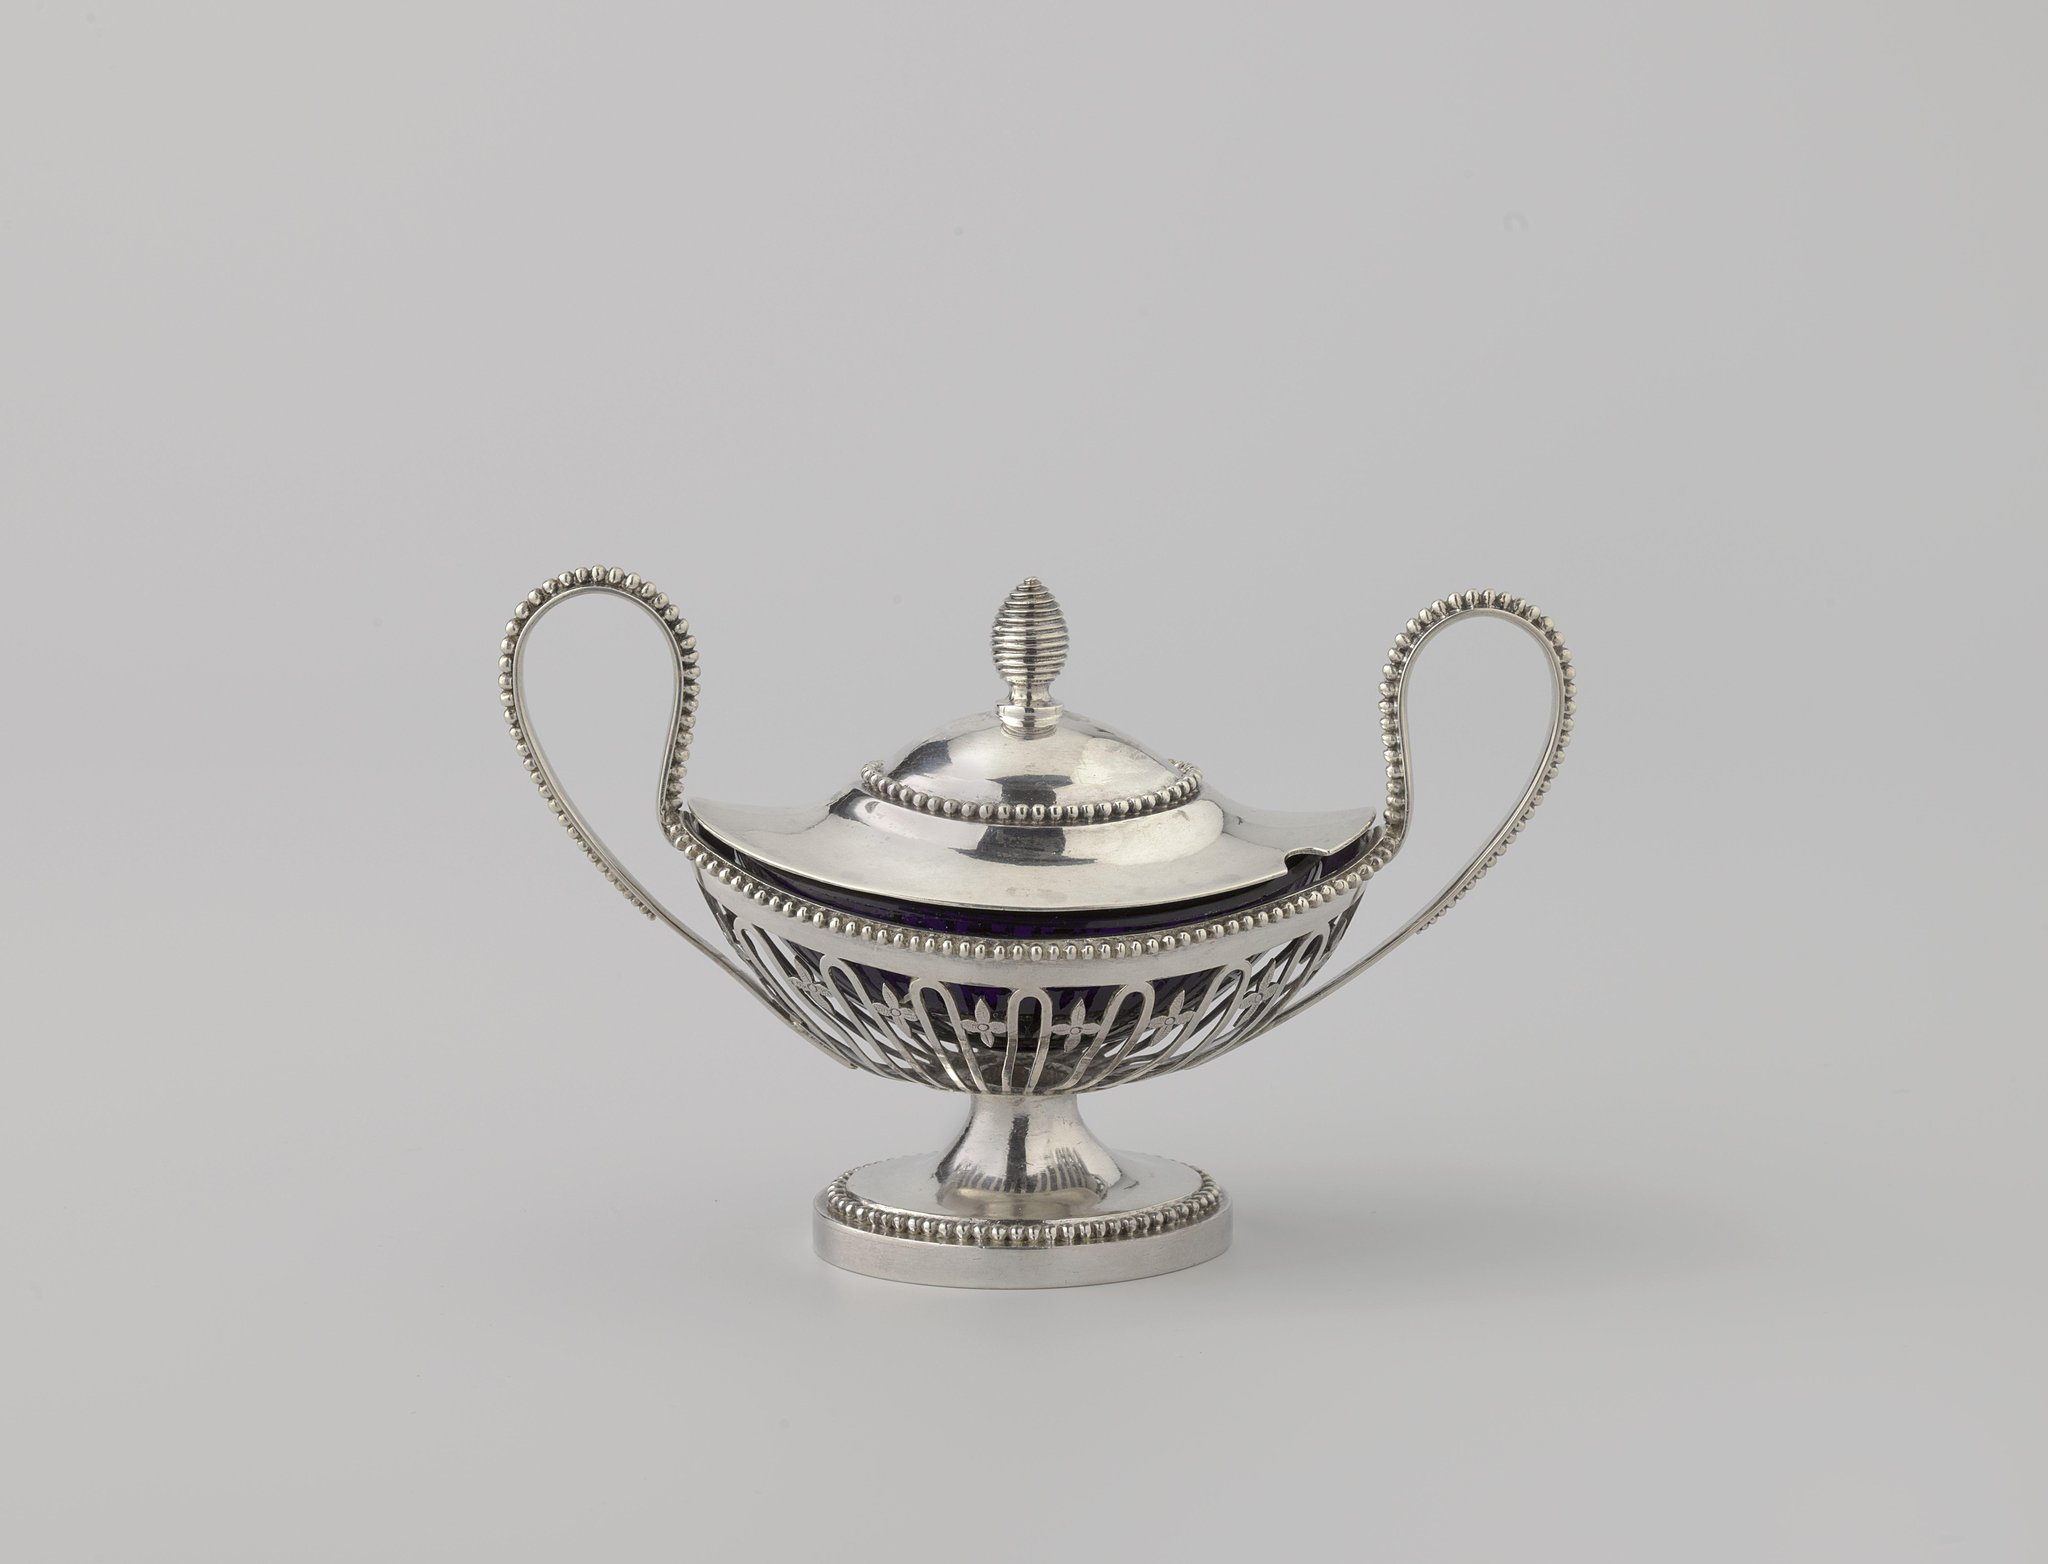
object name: mustard pot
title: Mosterdpot, spitsovaal, met opengewerkte wand met parellijsten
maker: nathanael teuter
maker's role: silversmith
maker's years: 1767-1831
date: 1805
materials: silver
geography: amsterdam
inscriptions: date letter: ‘W’, town mark, maker's mark, alloy mark, duty mark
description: De vier spits ovale, gewelfde vaten (A, B,C en D), die aan de zijkanten iets verhoogde wanden hebben, rusten elk op een ovale, zich naar boven sterk verjongende voet op een rechtwandige basis. Op het met afwisselend knerren en rozetten opengewerkte lichaam past een scharnierend, gewelfd deksel dat wordt bekroond door een geribde pijnappelvormige knop. Rond de voet, rond de bovenrand van het lichaam, over de hoog oplopende, gebogen oren en rond het deksel lopen parellijsten.